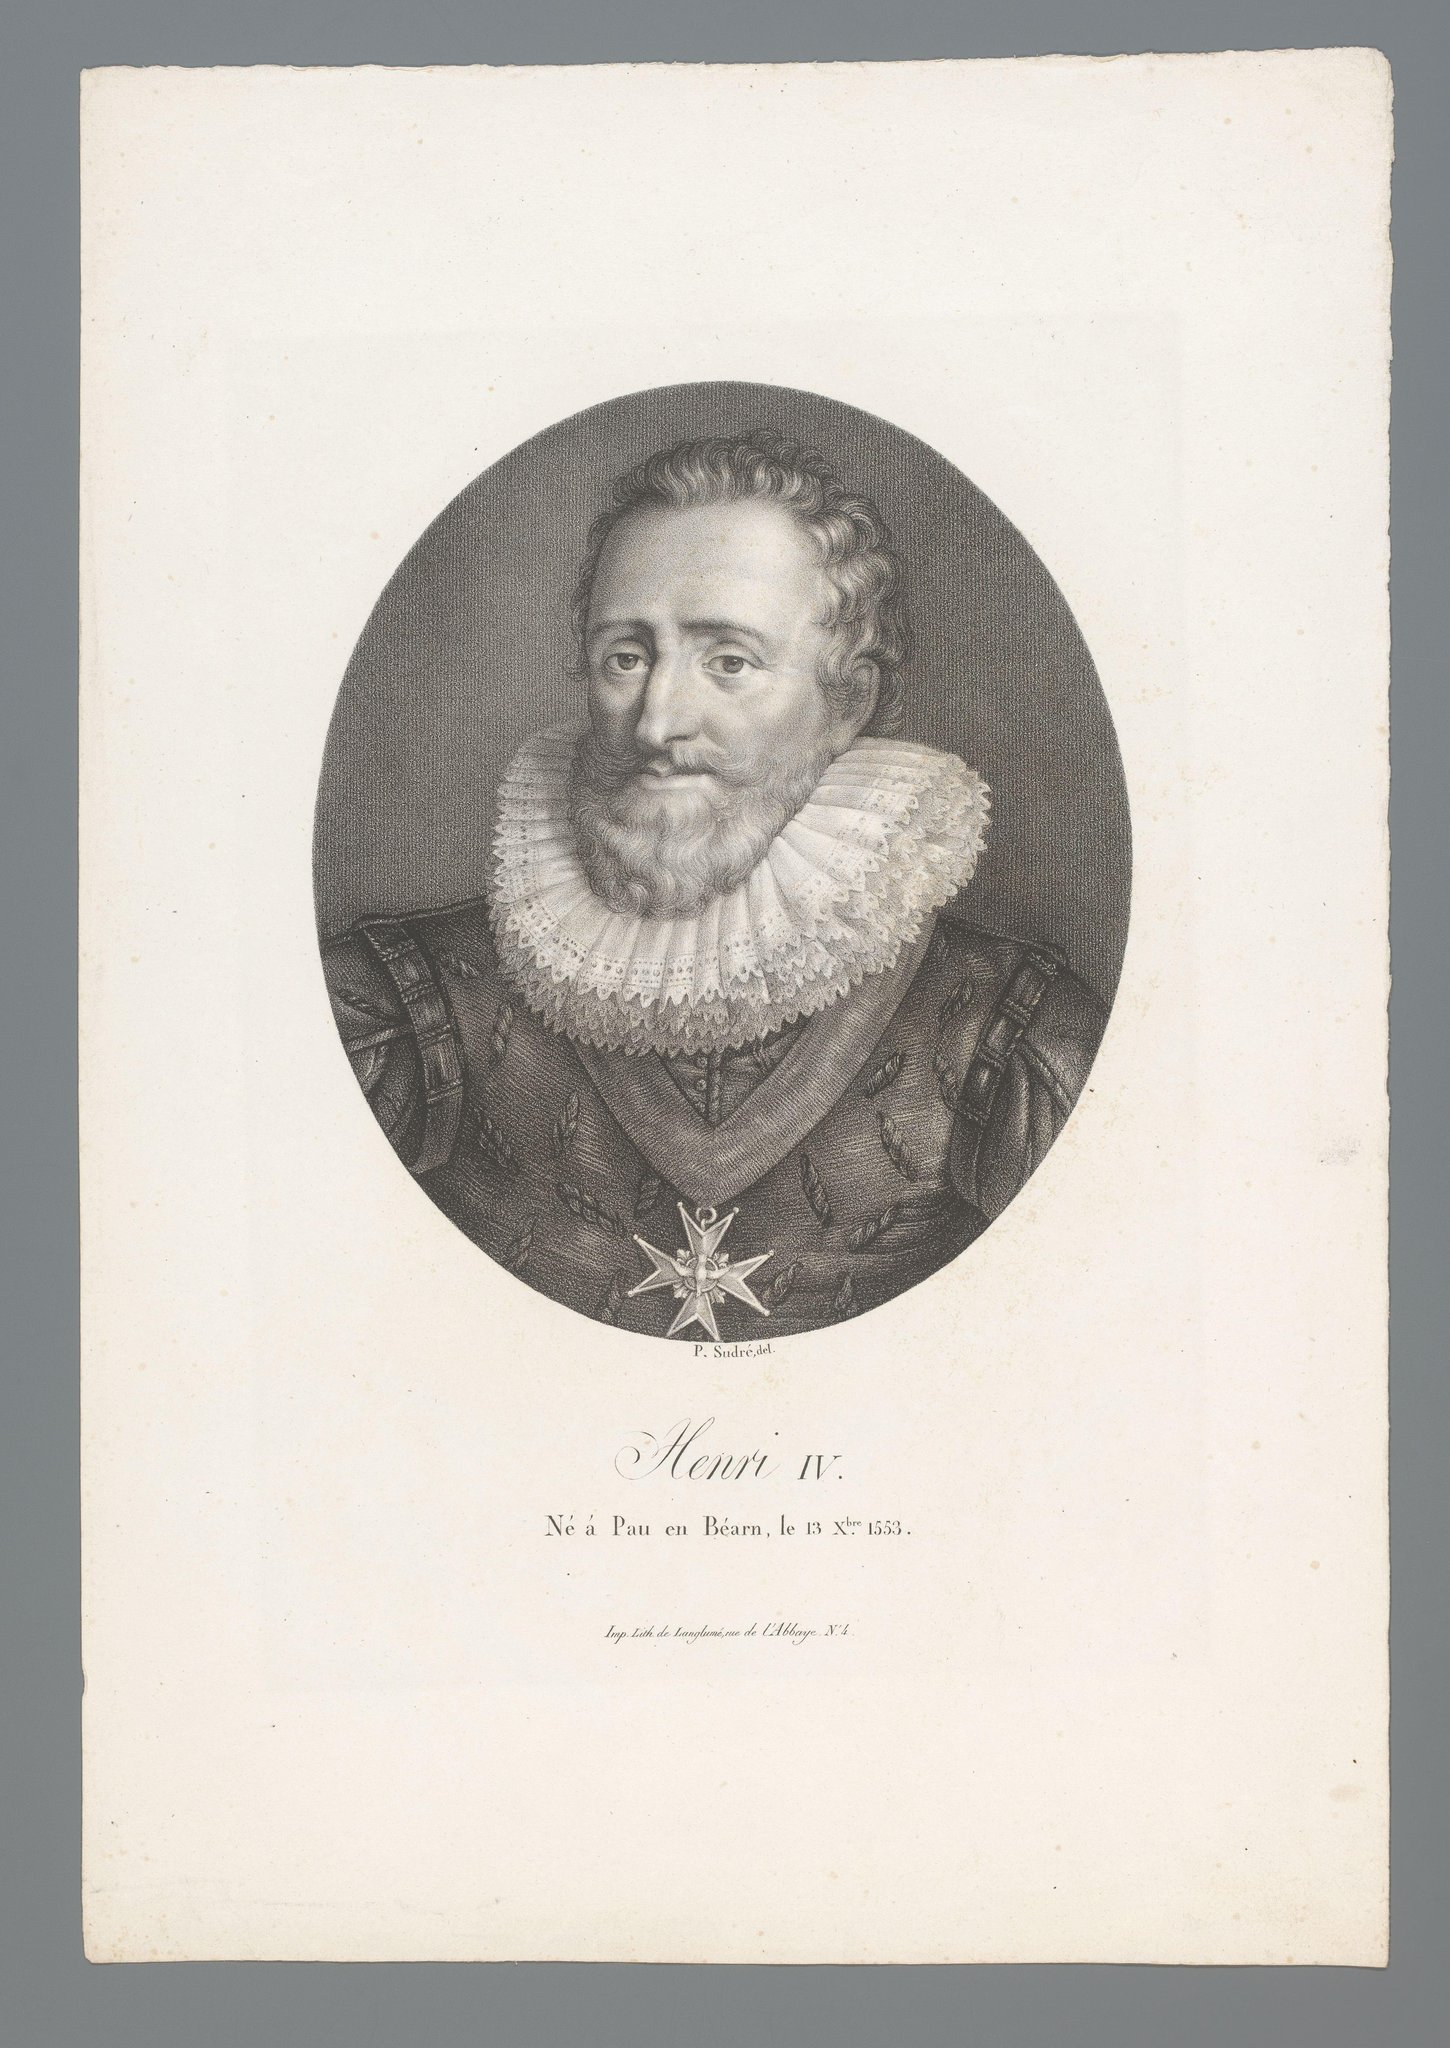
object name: print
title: Portretten van Franse beroemdheden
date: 1822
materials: paper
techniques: lithograph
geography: paris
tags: paris, hendrik iv (koning van frankrijk en navarra), historical persons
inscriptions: collector's mark: Lugt 2228